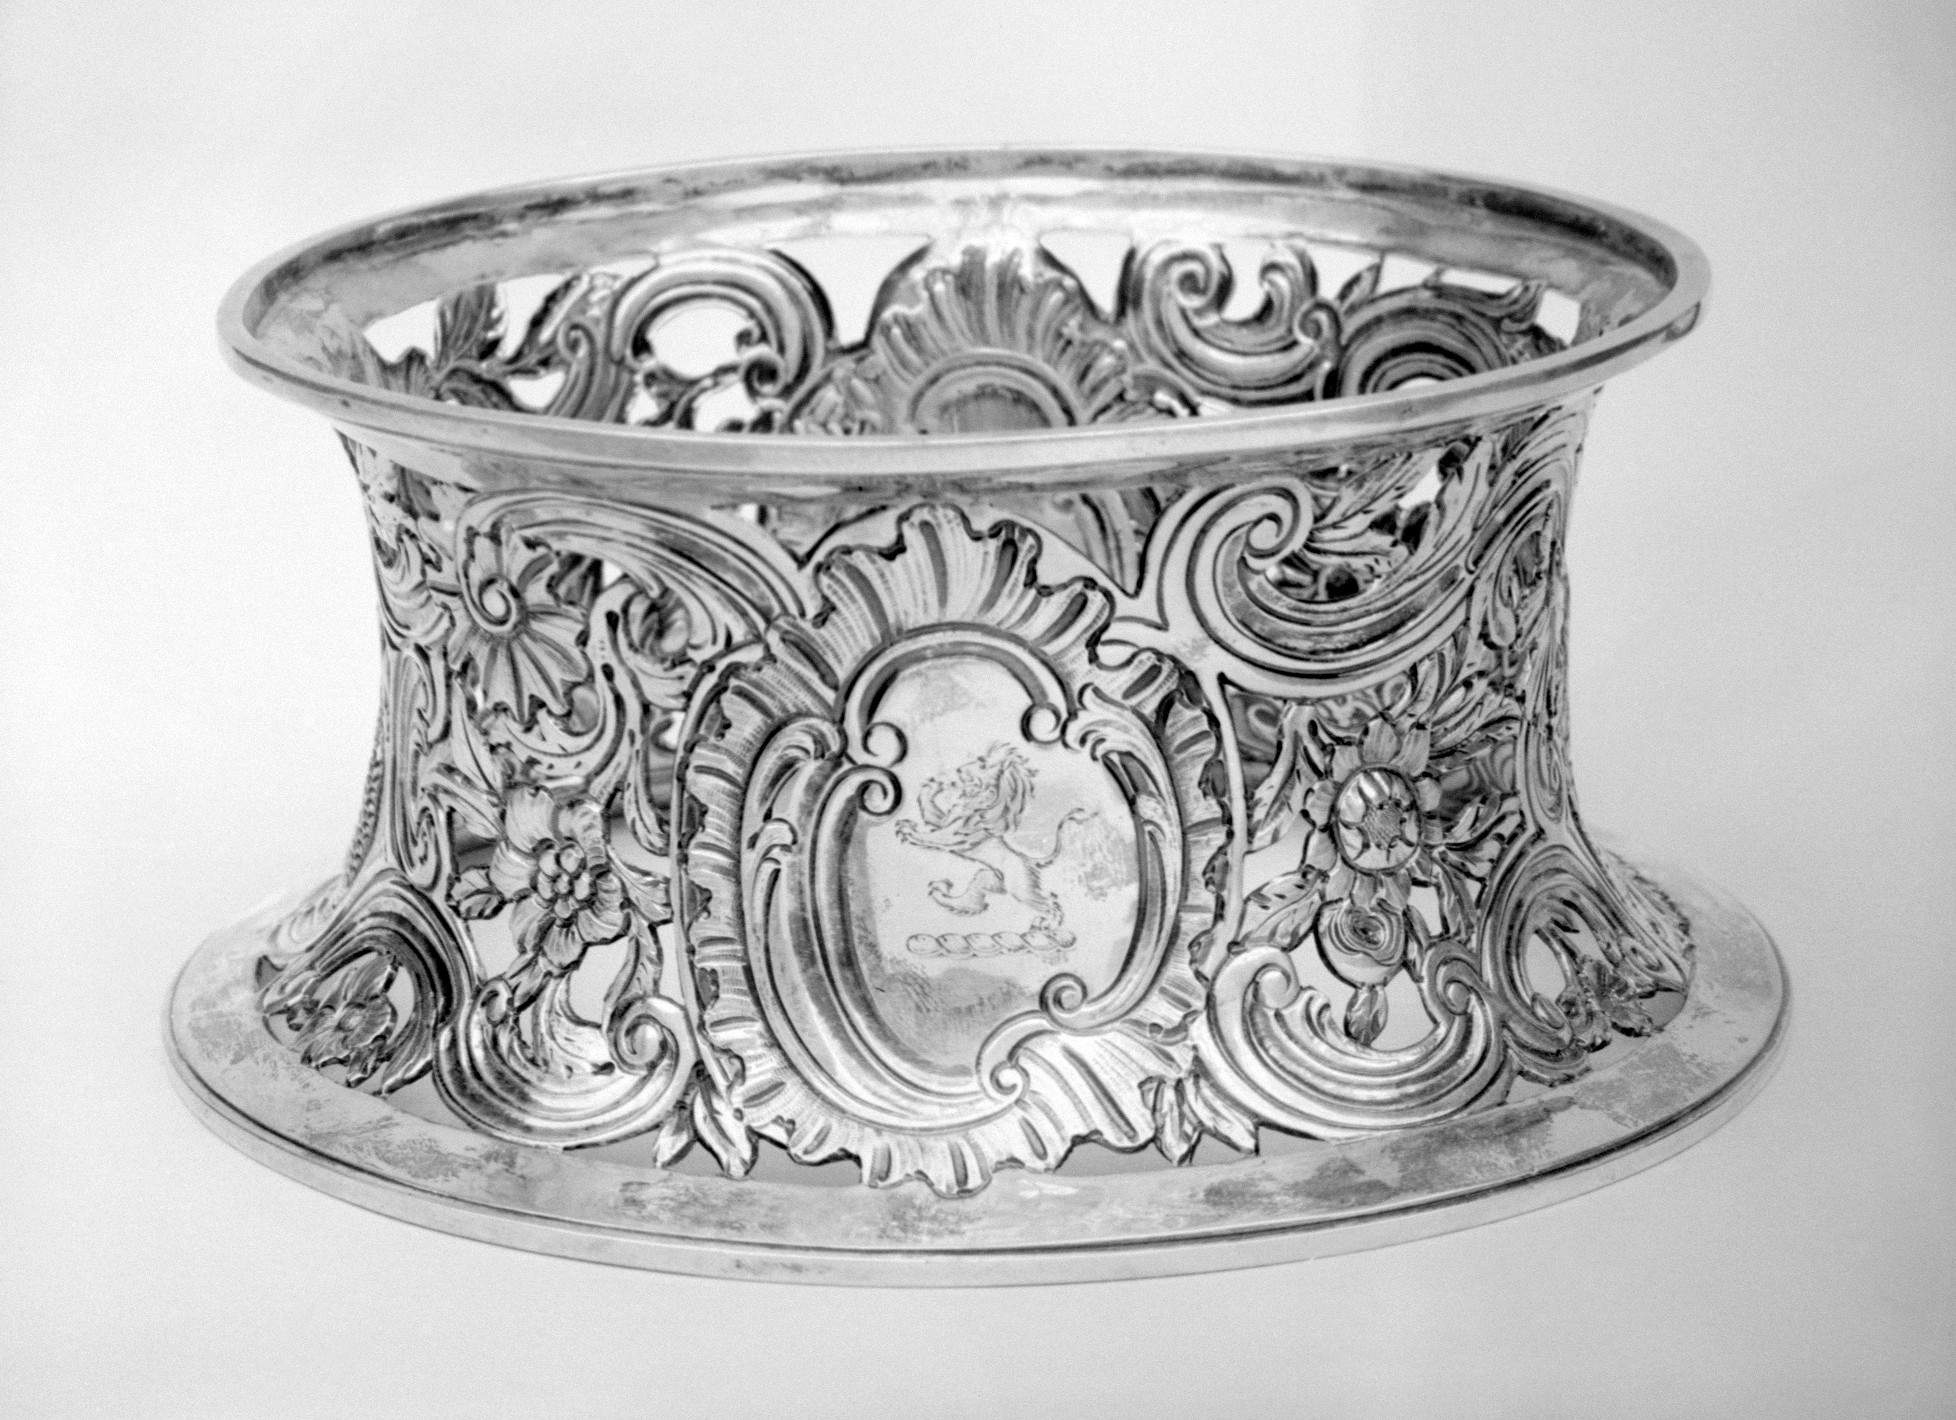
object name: dish ring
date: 1760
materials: silver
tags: lions,flowers